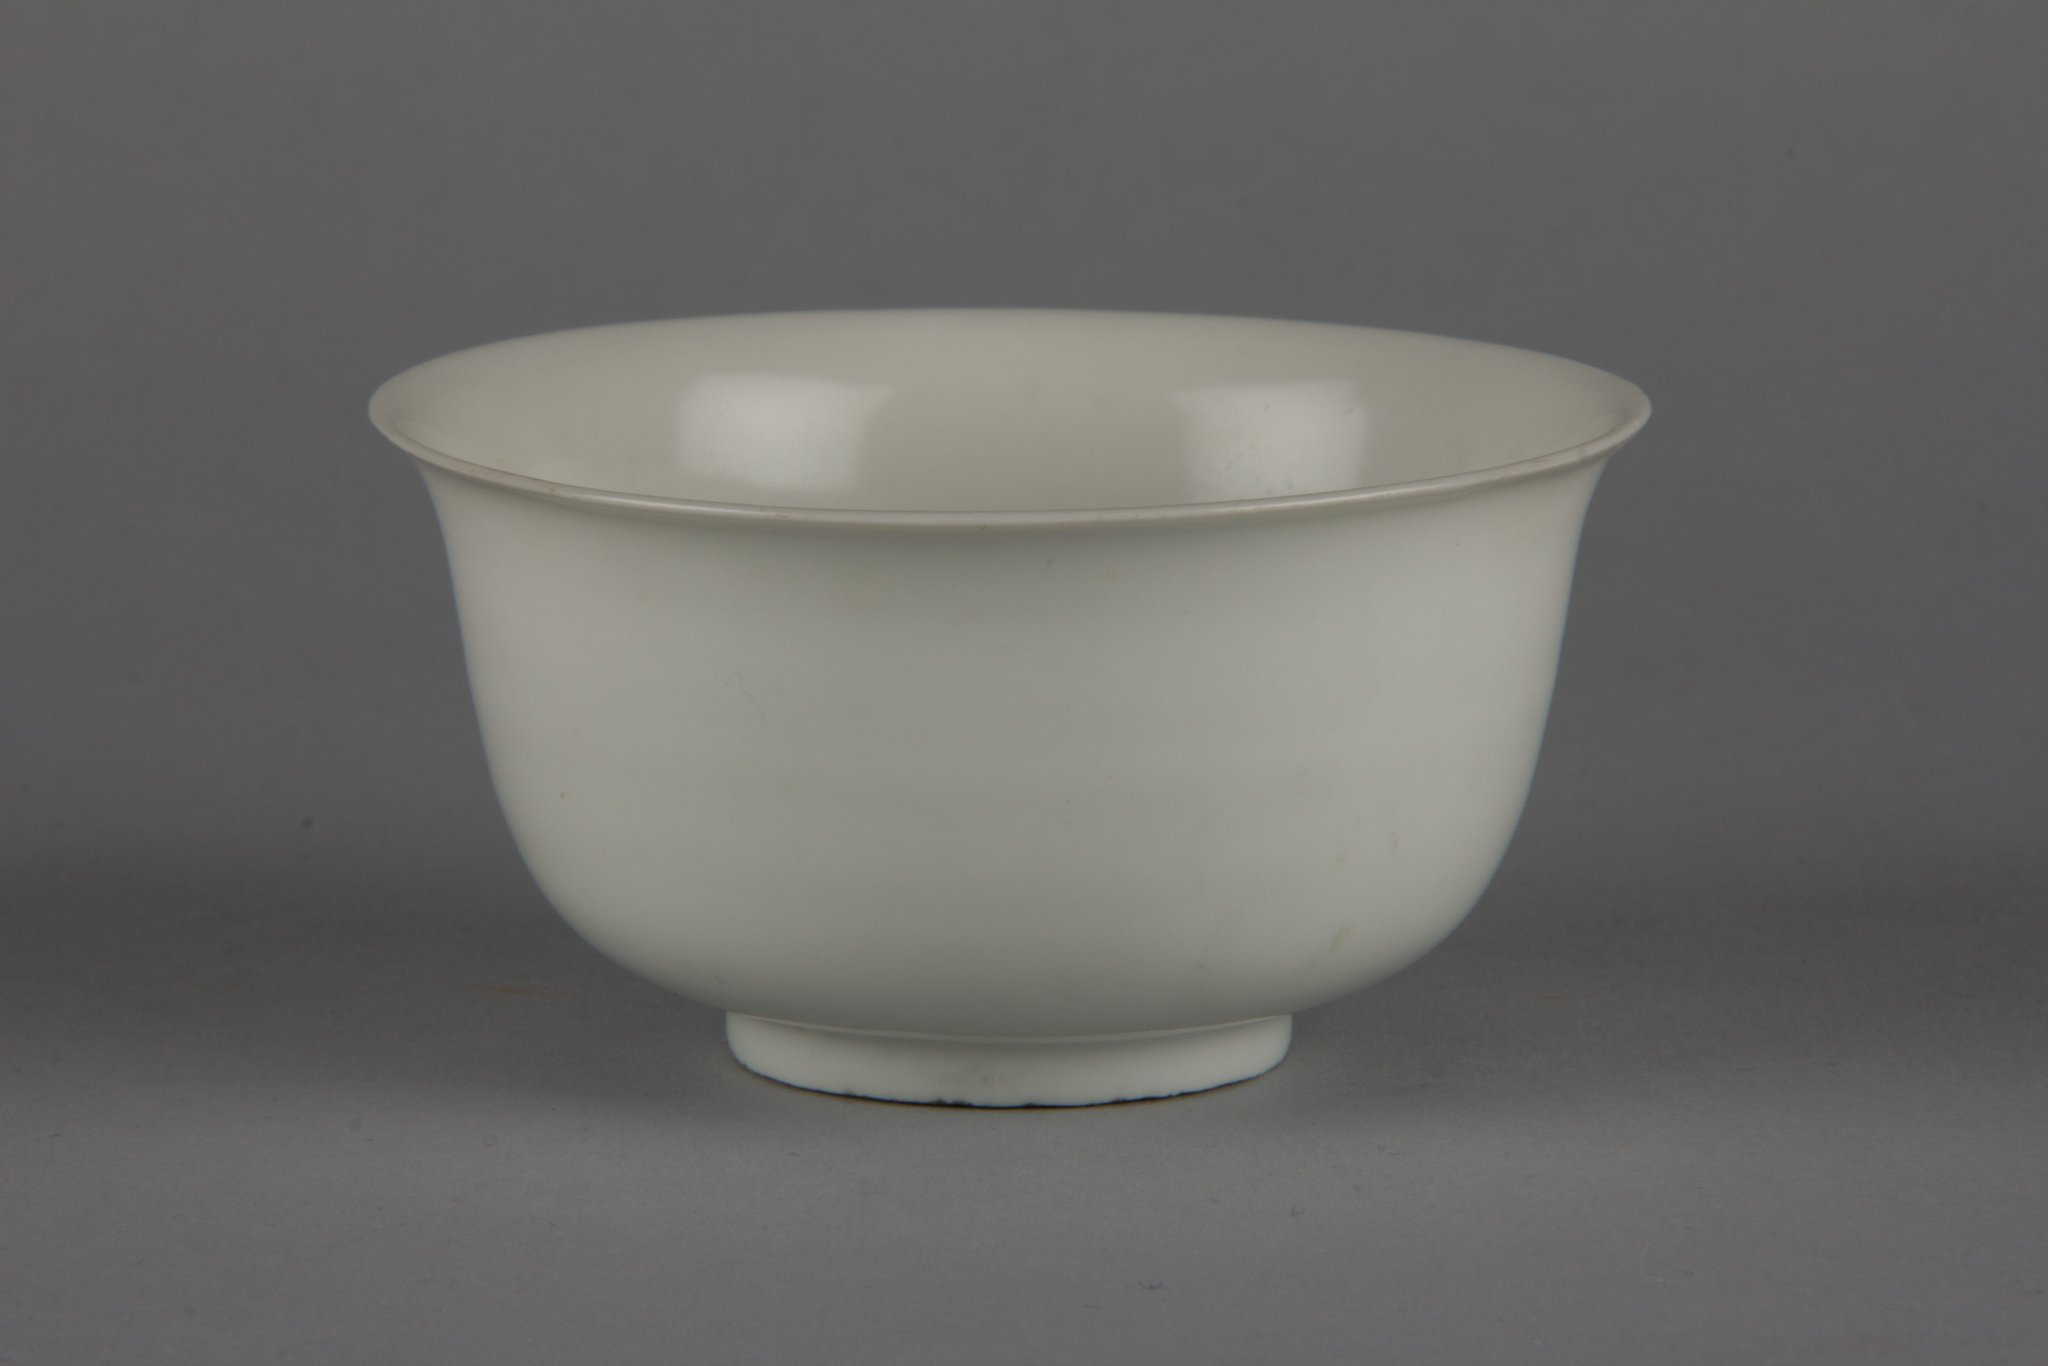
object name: bowl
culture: chinese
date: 1401-1500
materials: glaze, porcelain